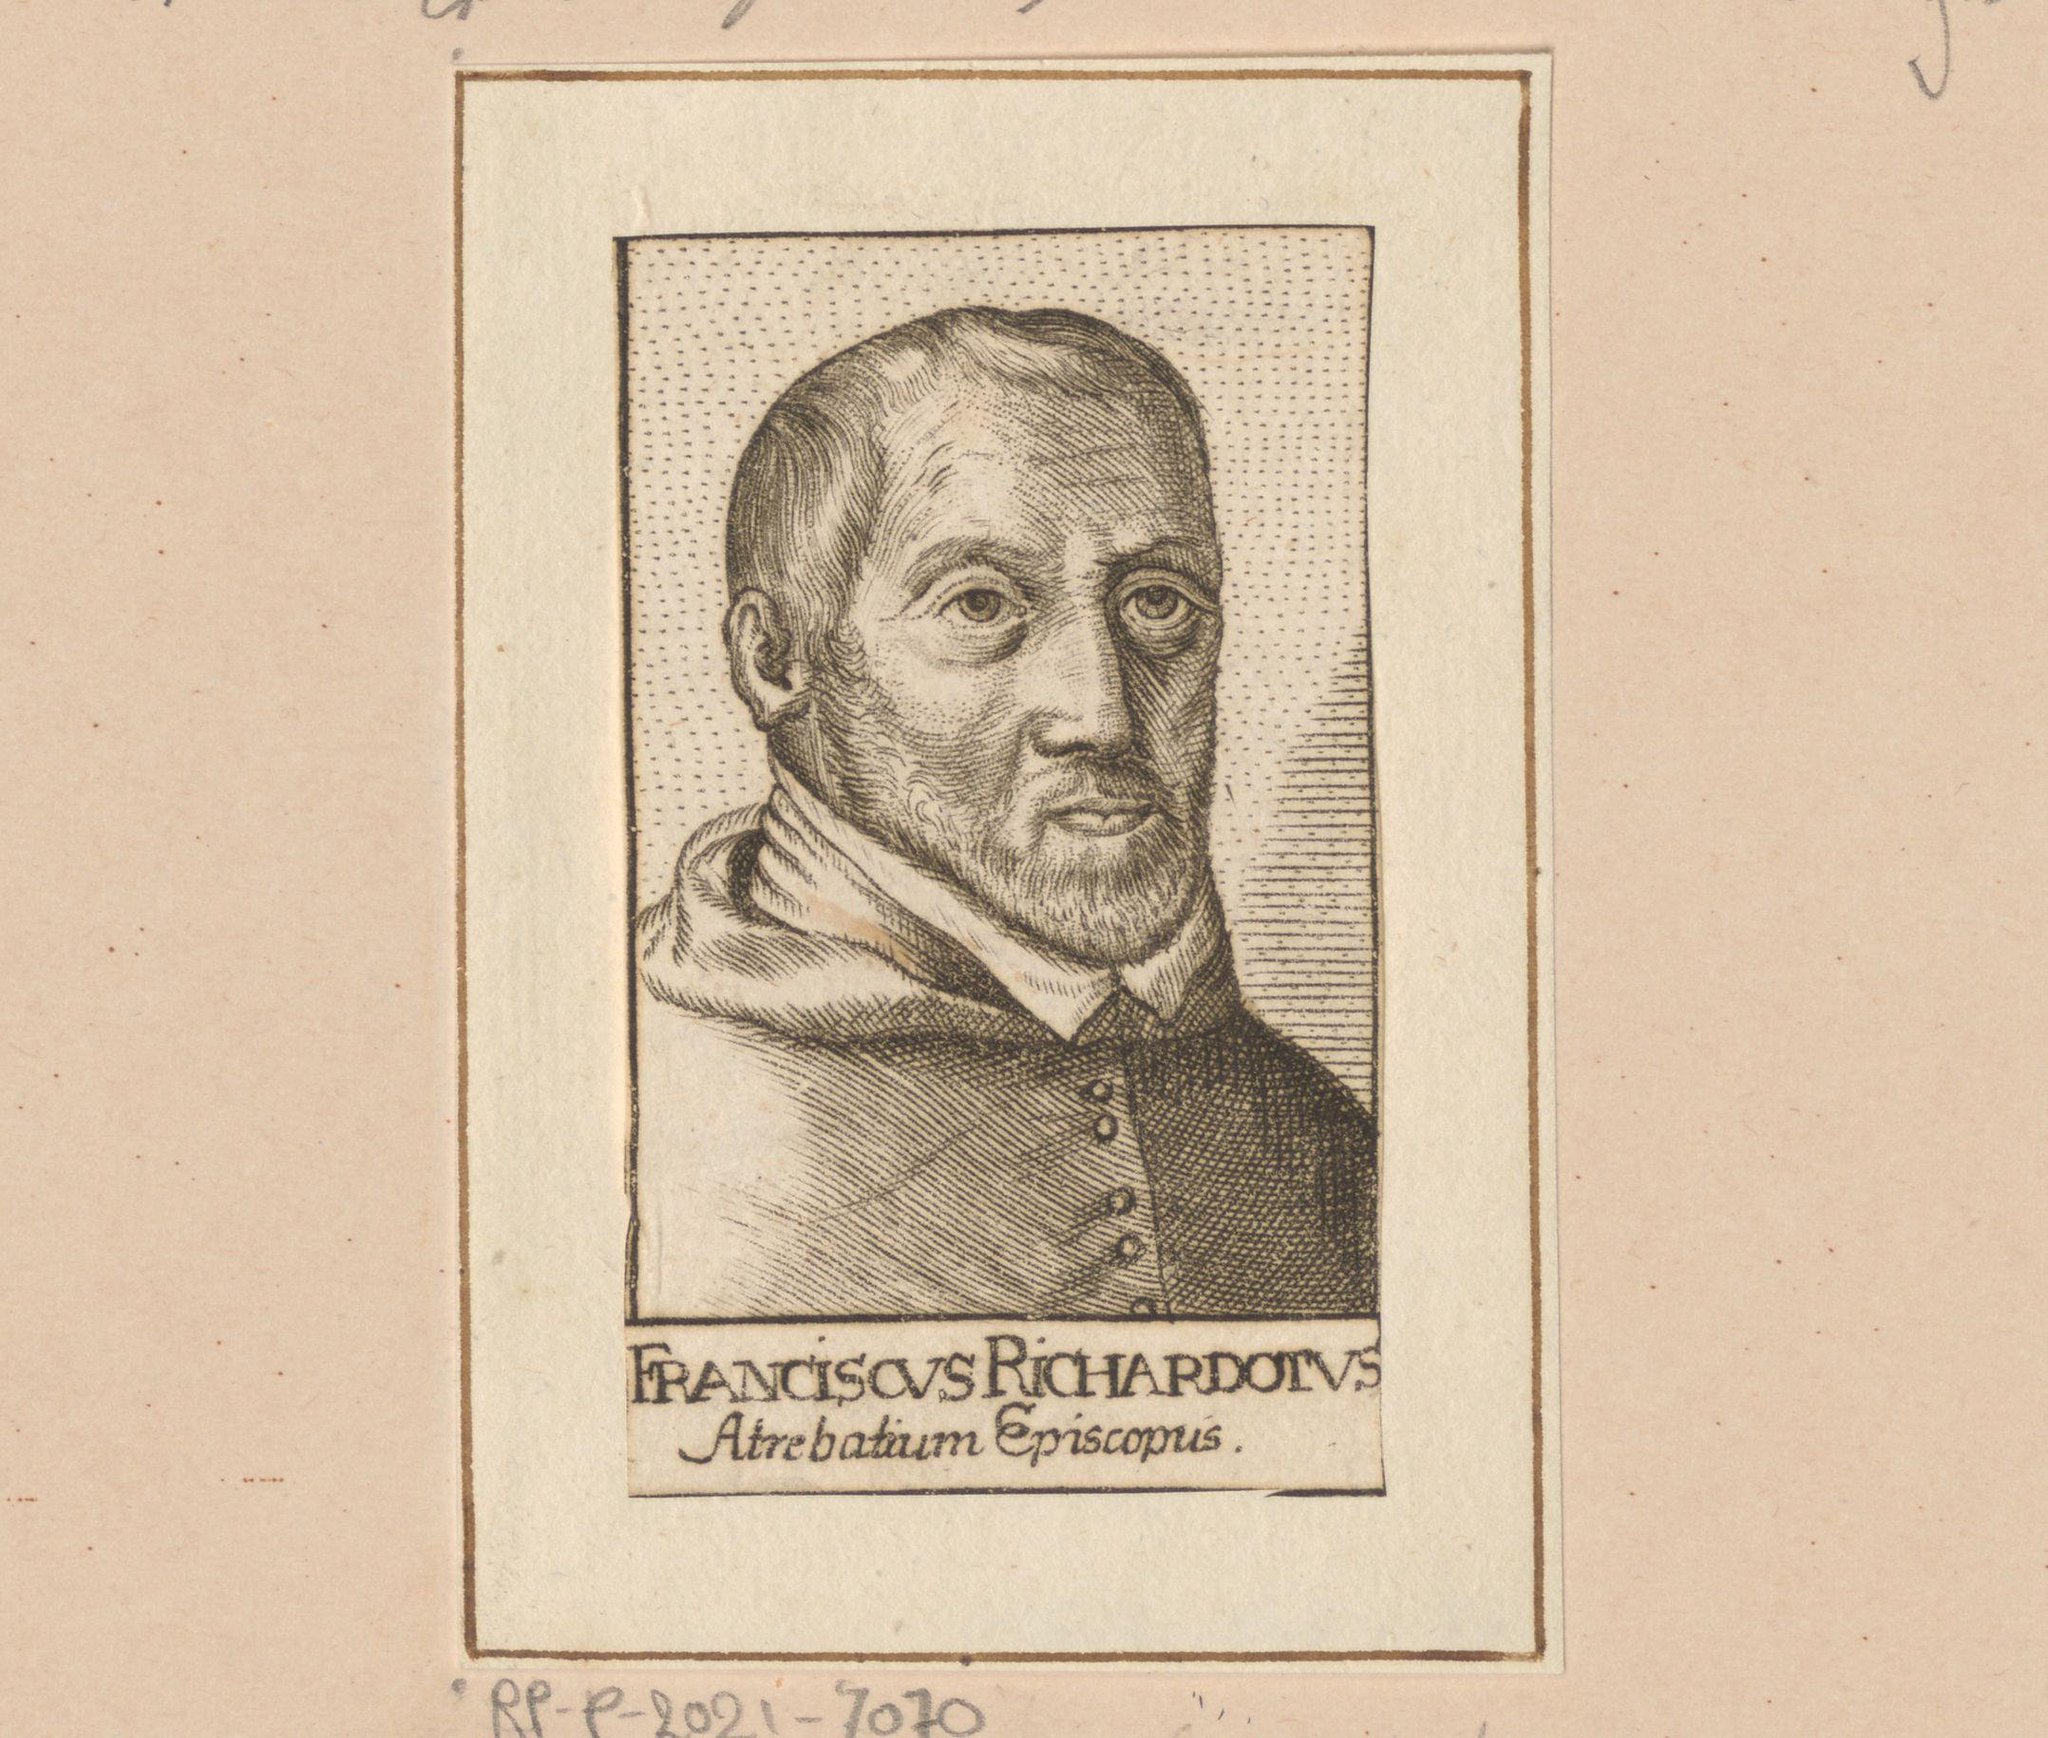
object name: print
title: Portret van François Richardot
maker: Anonymous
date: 1688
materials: paper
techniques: engraving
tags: historical persons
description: Prent maakt deel uit van een grotere prent die later is verknipt. Prent waarschijnlijk uit: Freher, Paul. Theatrum virorum eruditione clarorum. Neurenberg: Johann Hoffmann, 1688.